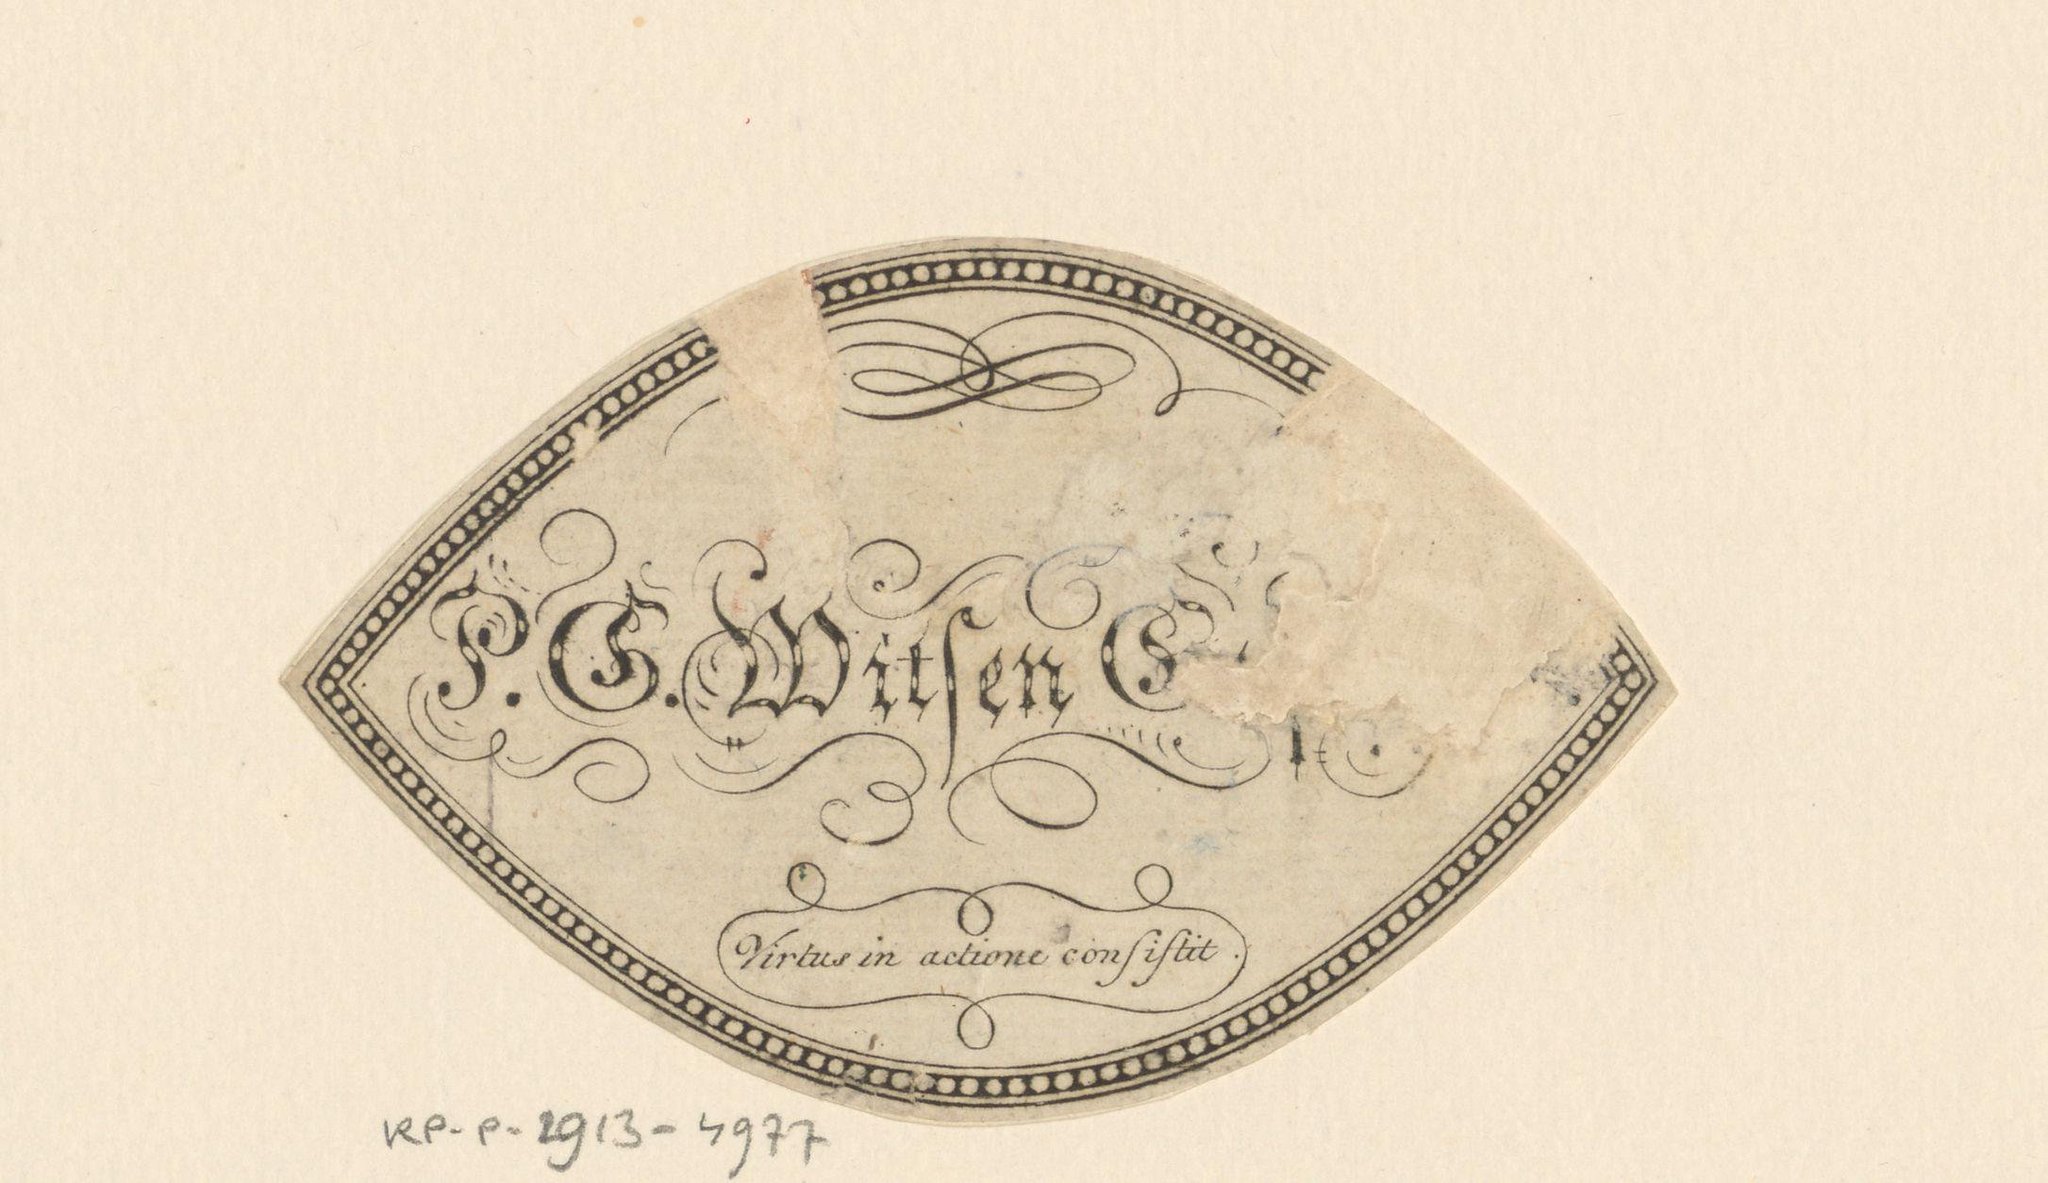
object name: bookplate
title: Virtus in Actione consistit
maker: Anonymous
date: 1784-1833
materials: paper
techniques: etching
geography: netherlands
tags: amsterdam, pieter gerardus witsen geysbeek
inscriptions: collector's mark: Lugt 2233, collector's mark: Lugt 2760